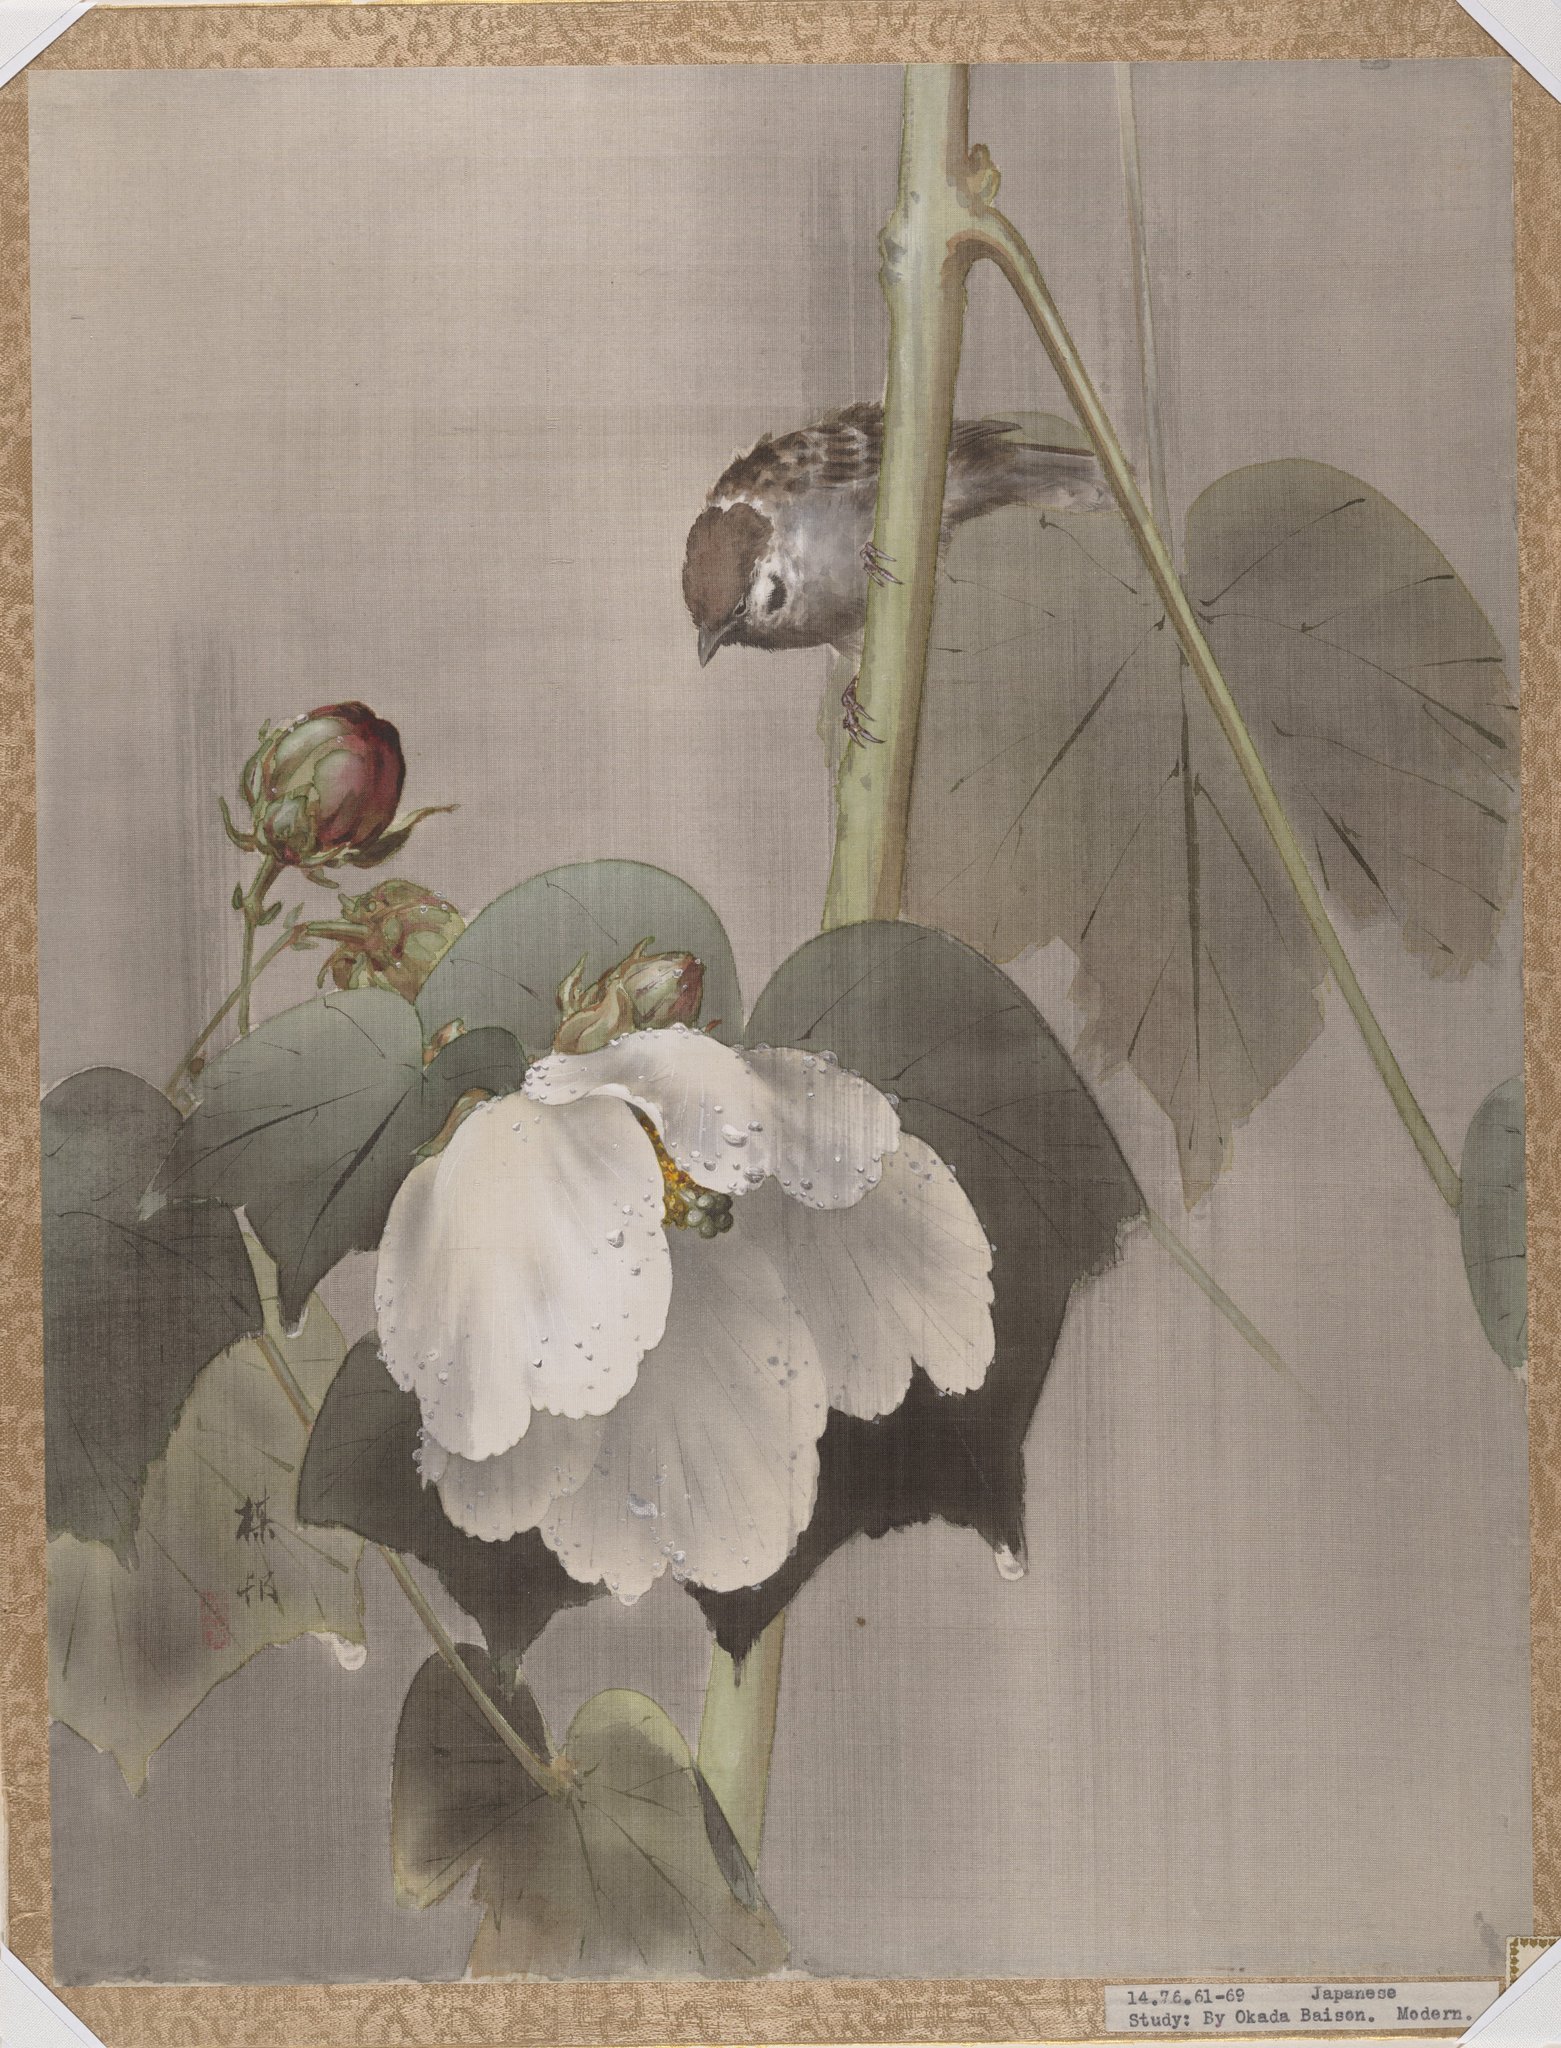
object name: album leaf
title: Cotton Rose Mallows in the Rain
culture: japanese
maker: okada baison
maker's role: artist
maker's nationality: japanese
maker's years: 1864-1913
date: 1891-1892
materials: ink, silk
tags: birds,roses